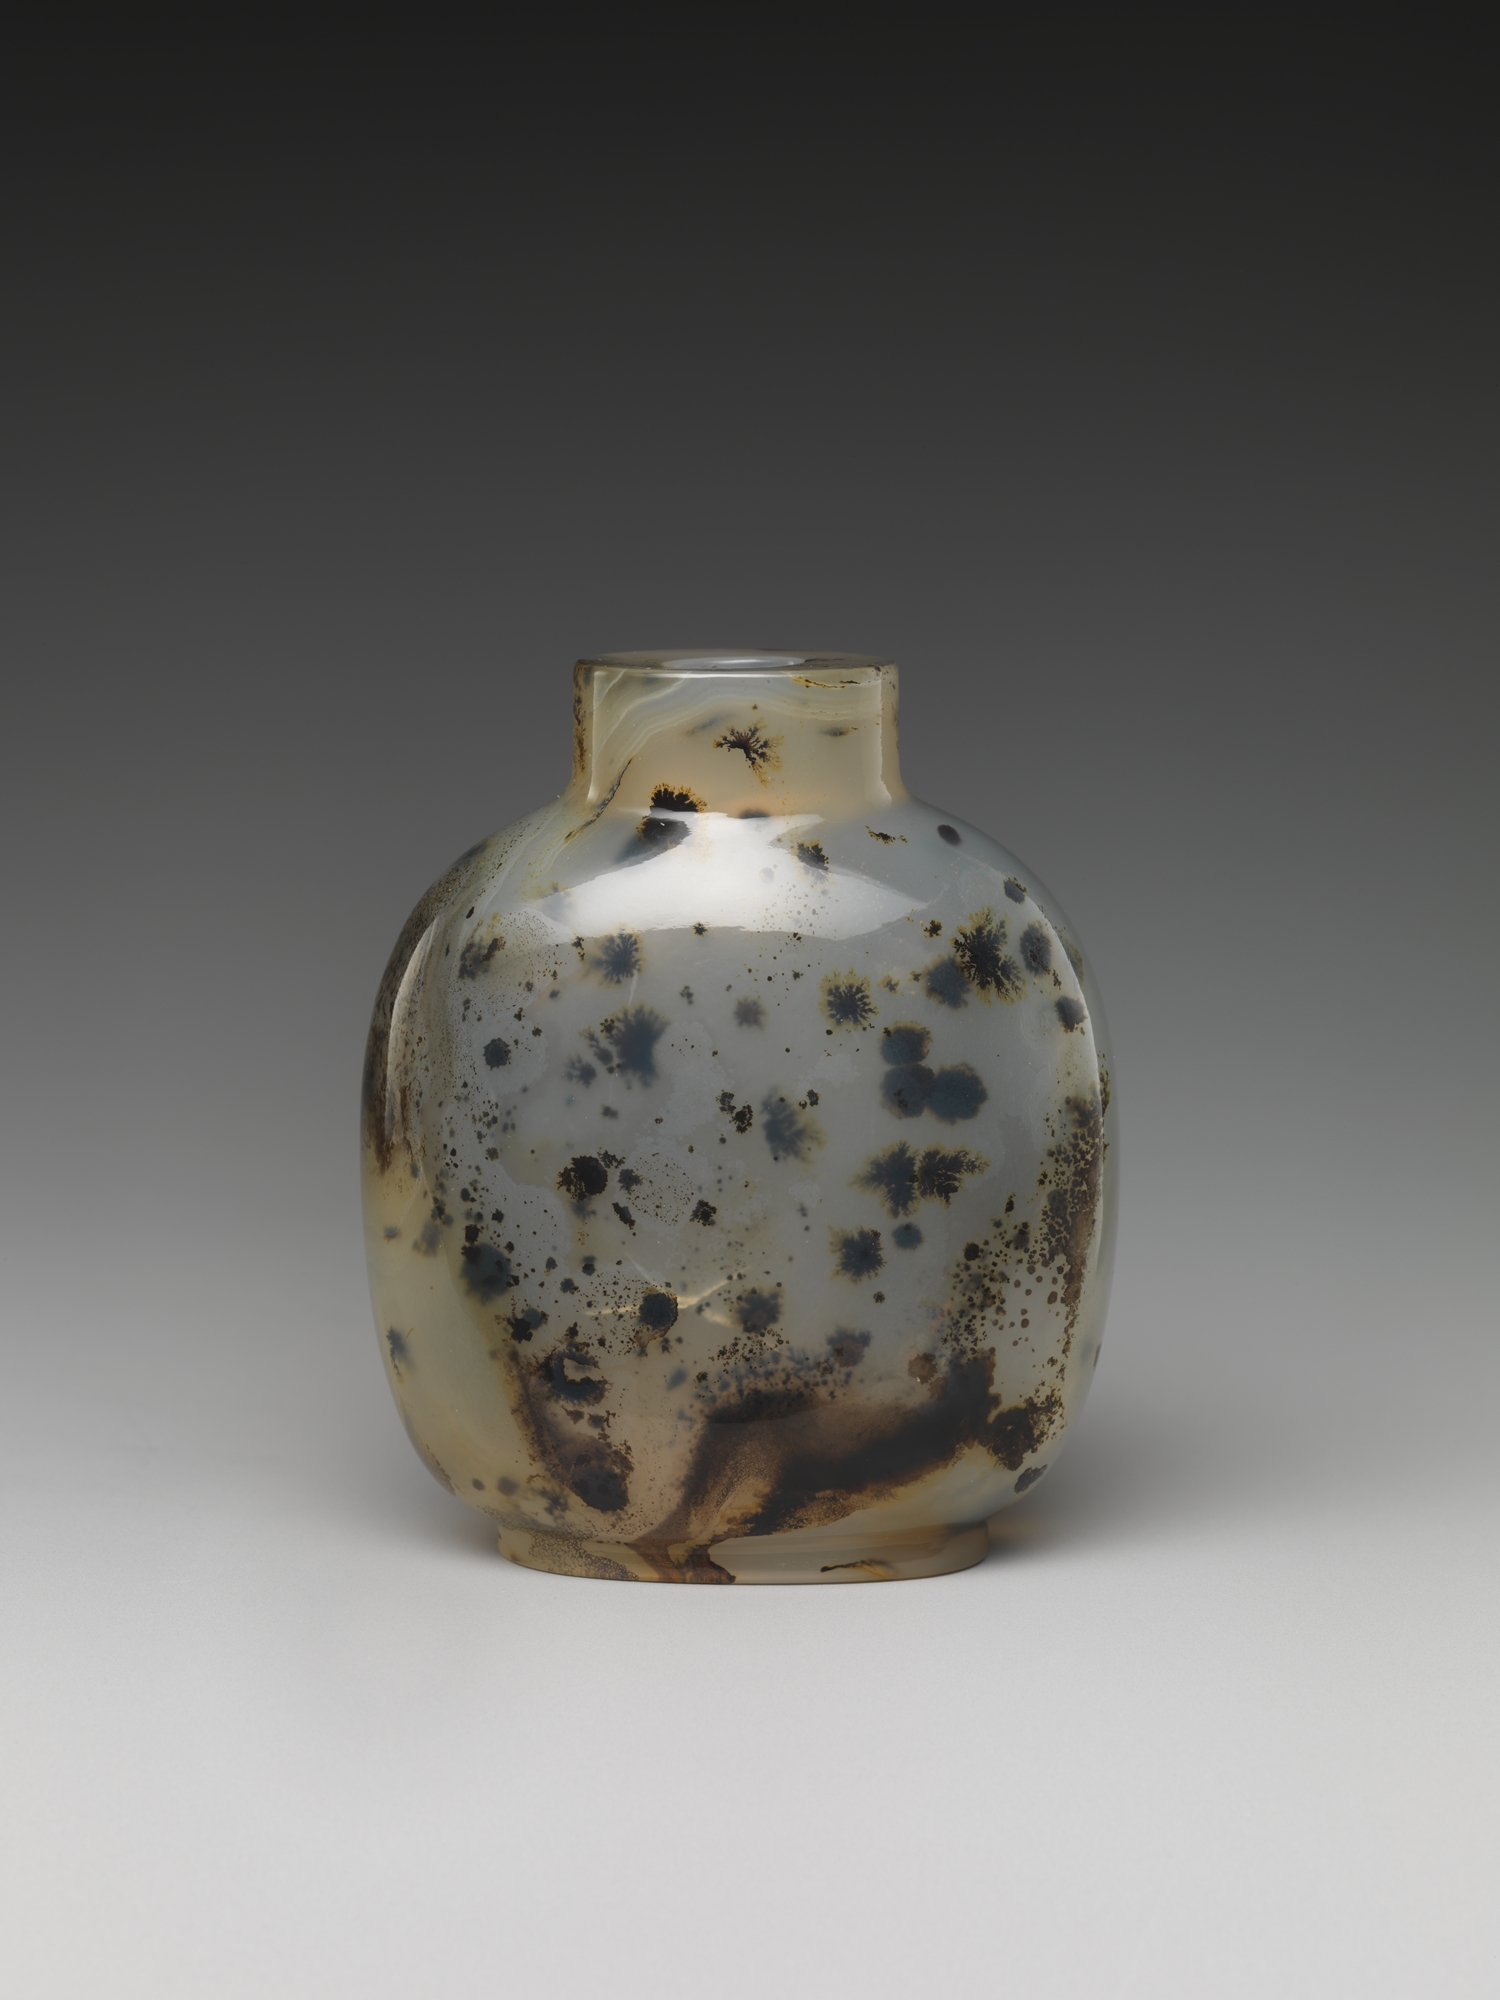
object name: snuff bottle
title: Snuff Bottle with the Artist Mi Fu Bowing to a Rock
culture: chinese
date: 1767-1833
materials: stone